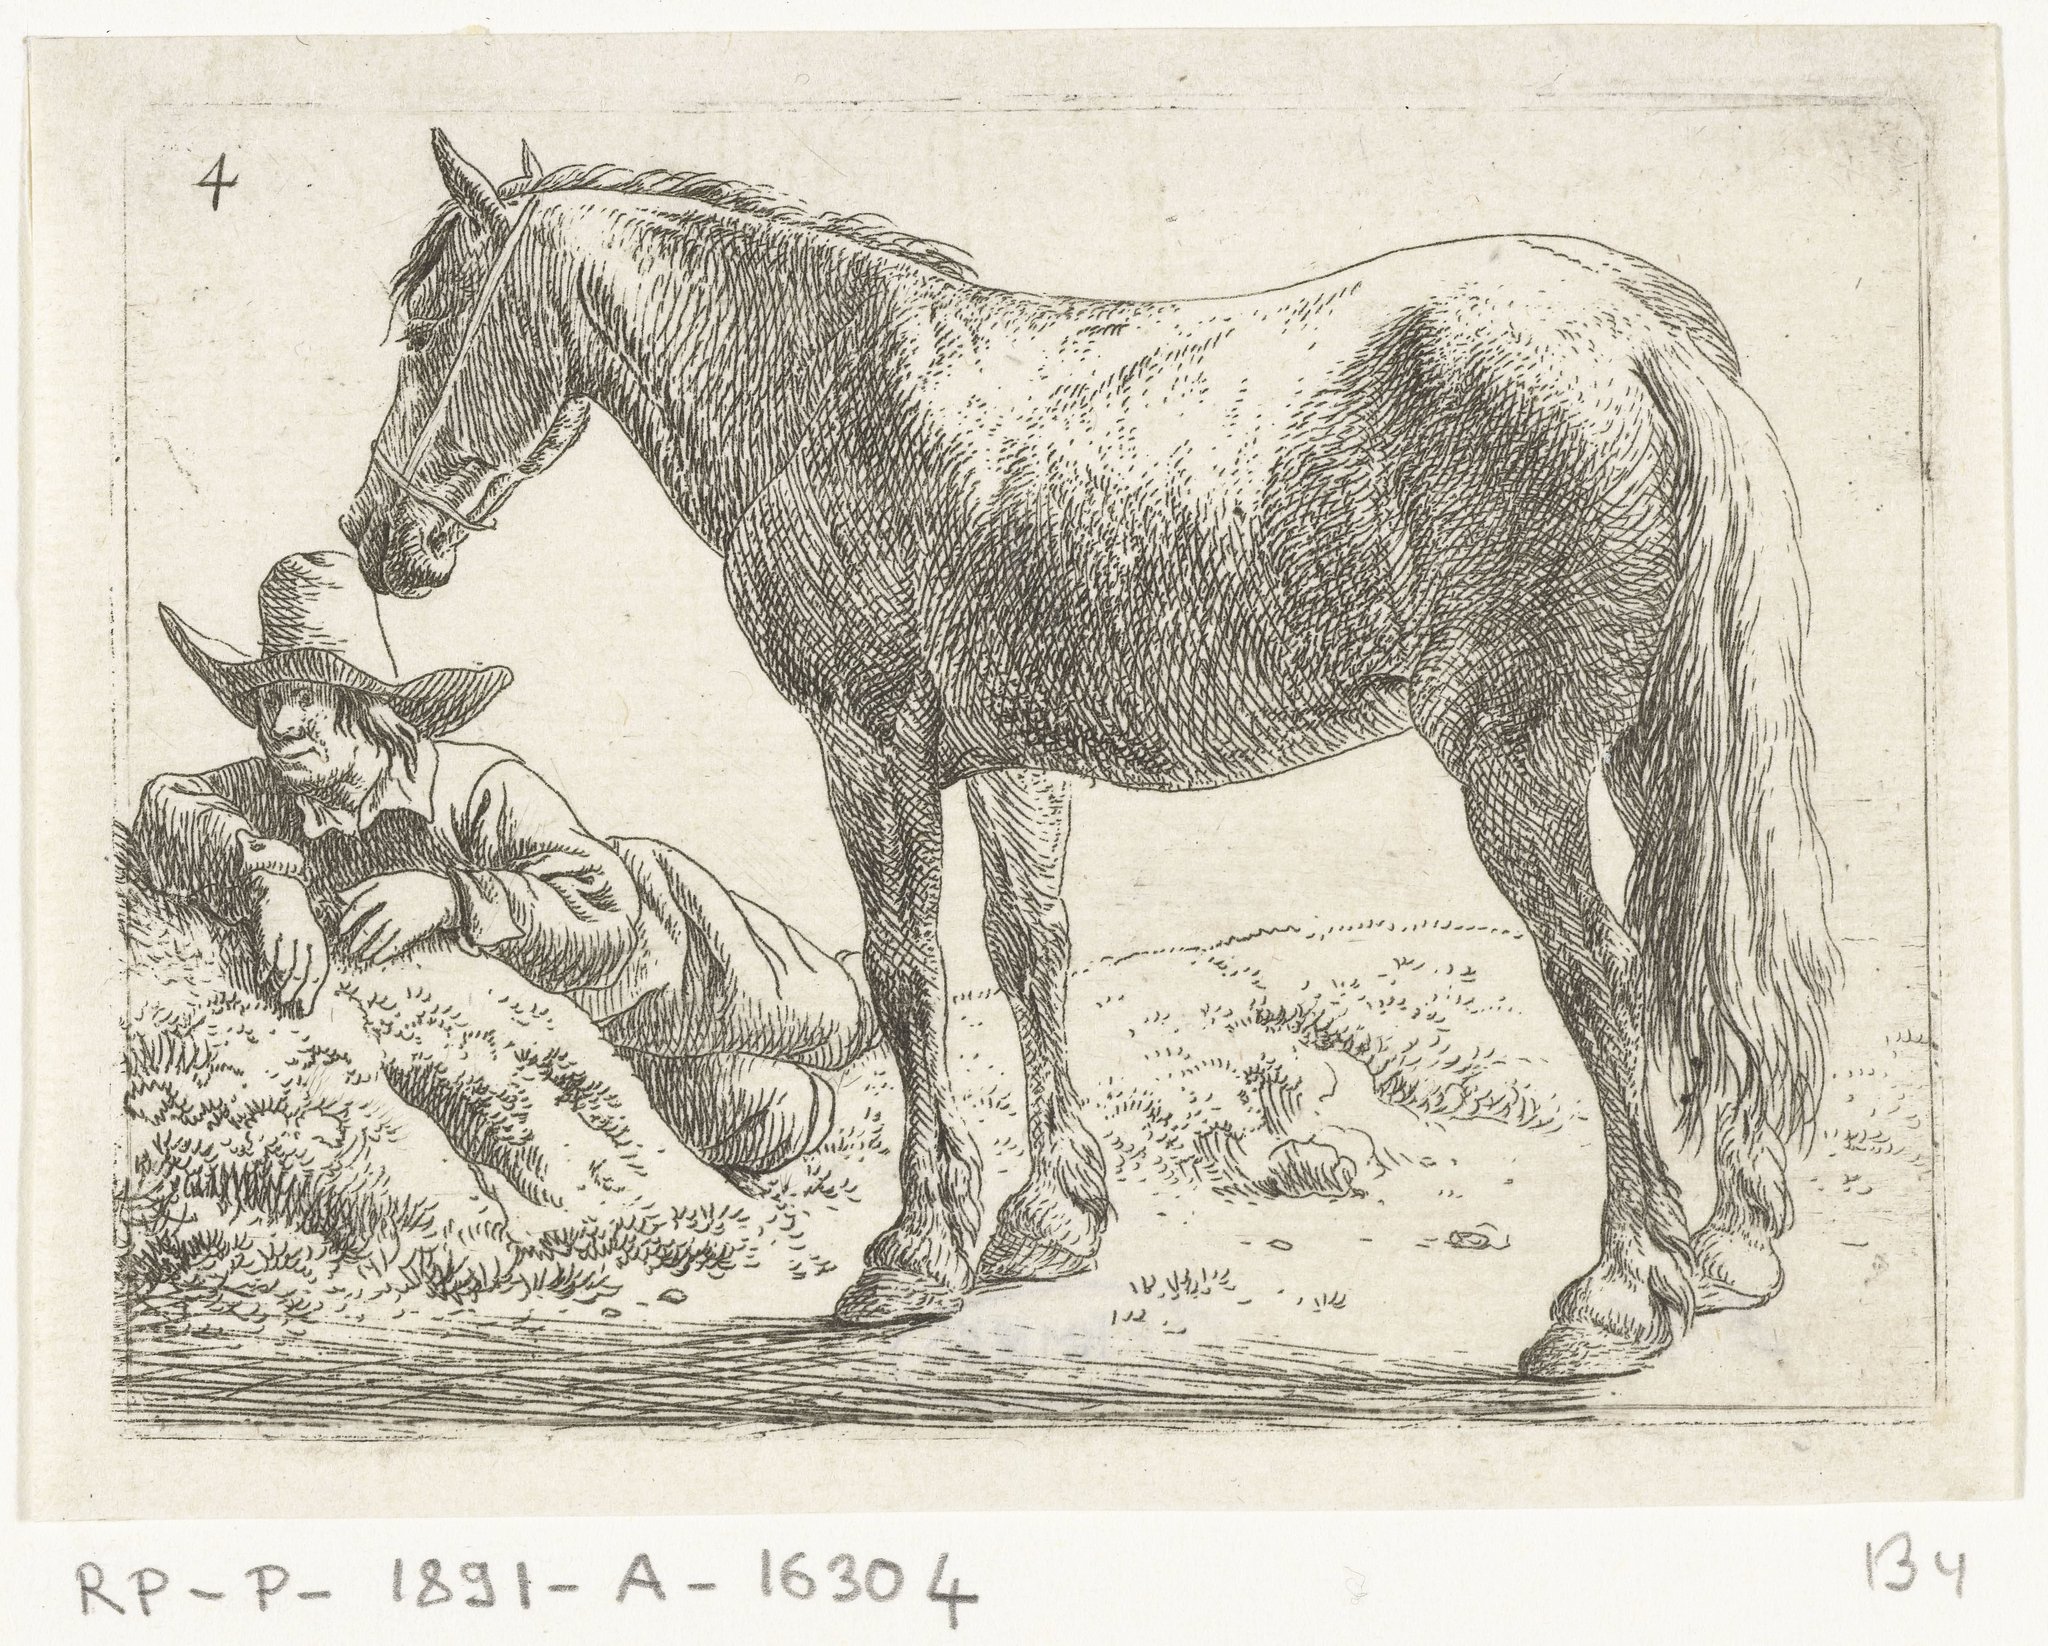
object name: print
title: Staand paard met rustende ruiter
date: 1624-1661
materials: paper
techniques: etching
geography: amsterdam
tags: horse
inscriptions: collector's mark: Lugt 2228, collector's mark: Lugt 2228a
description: Landschap met staand paard. Links ligt een man op zijn buik in het gras.